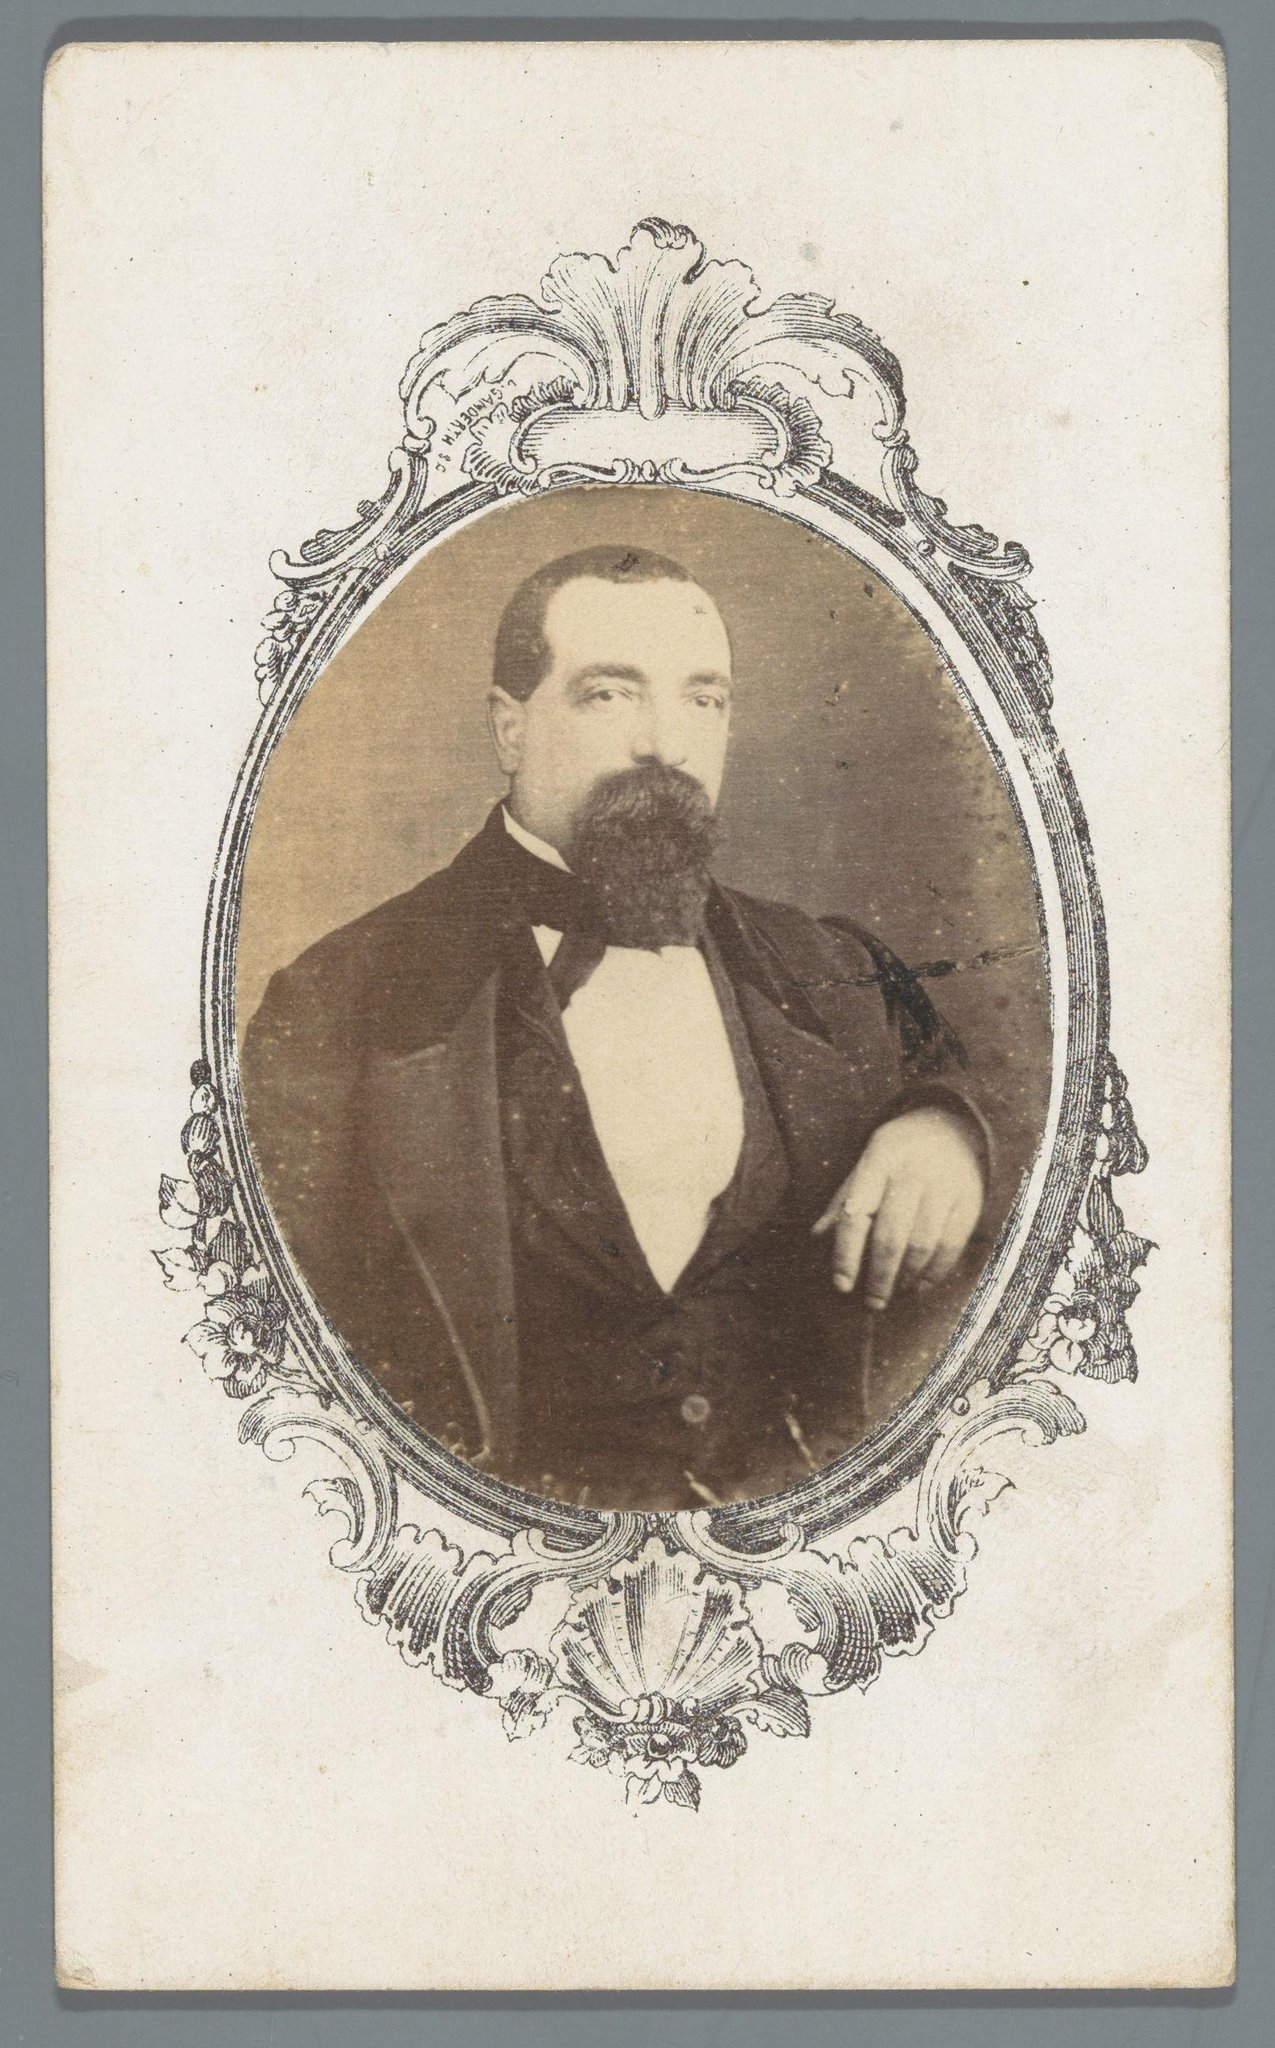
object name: carte de visite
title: Portret van een onbekende man met baard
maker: l. gamberth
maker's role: fotograaf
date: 1855-1885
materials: cardboard, paper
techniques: albumen print, lithograph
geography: south carolina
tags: adult man, anonymous historical person portrayed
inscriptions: inscription: ‘L. Gamberth S.C.’